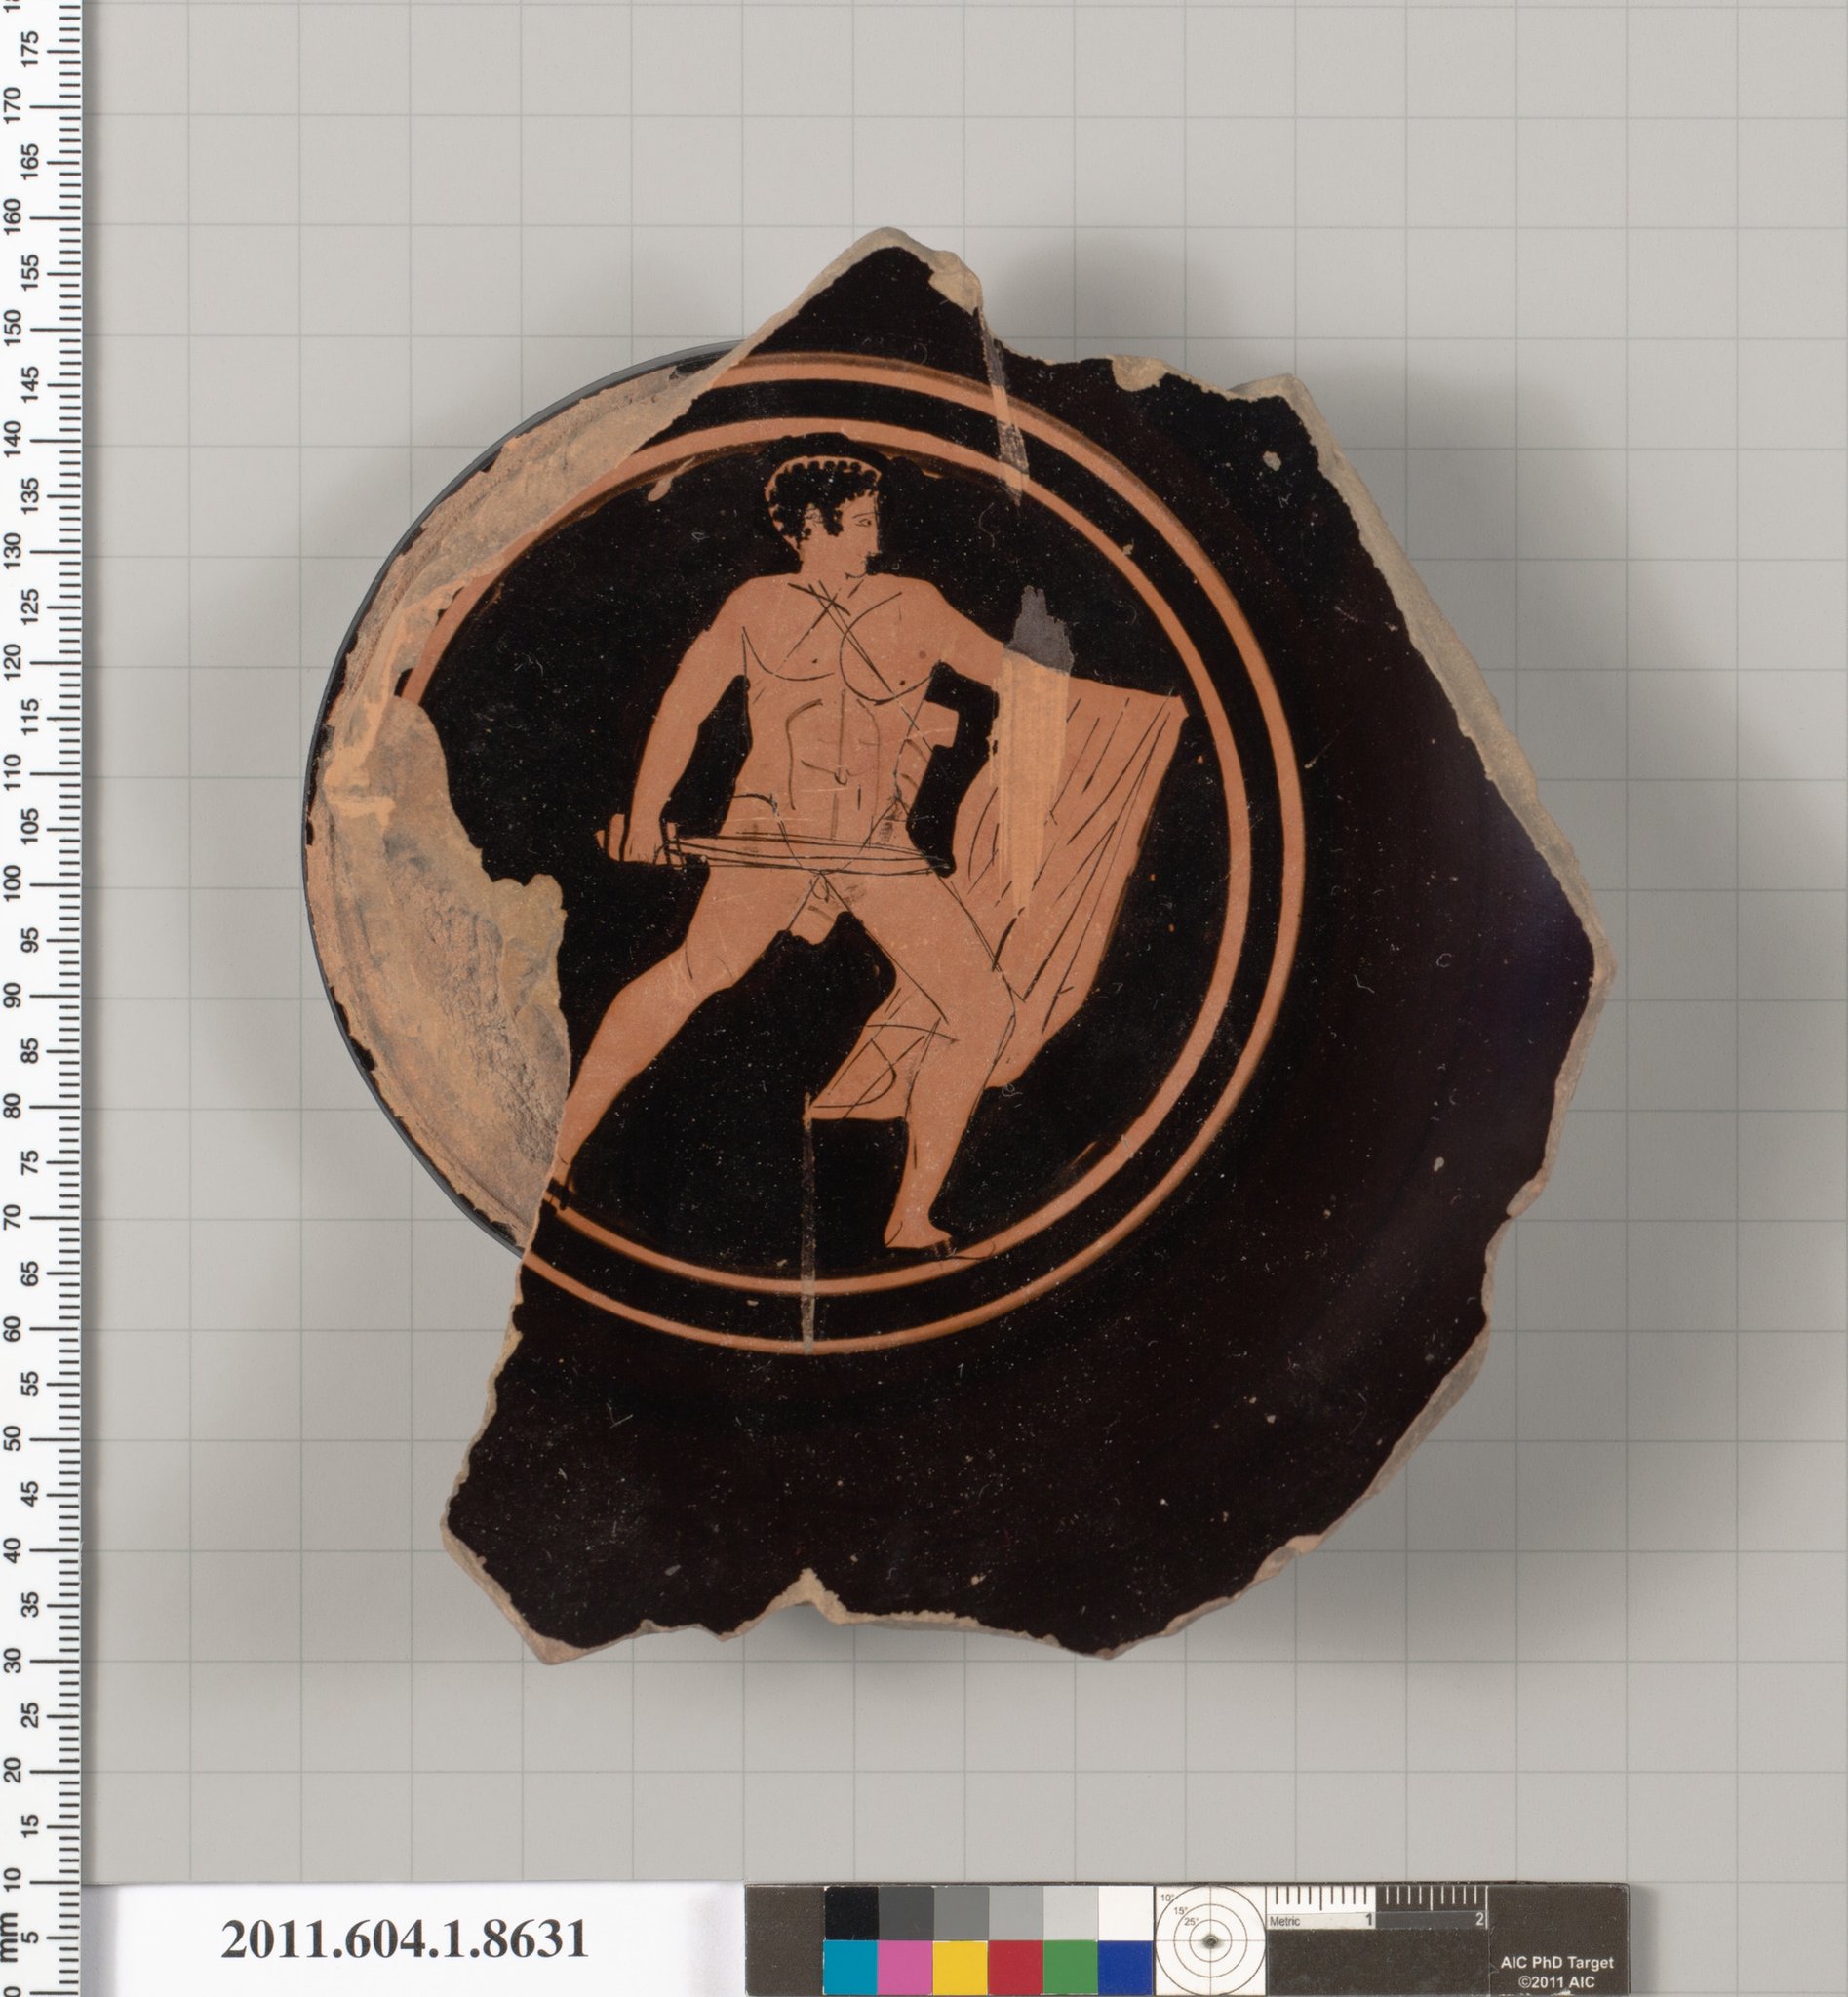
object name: kylix fragment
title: Terracotta fragment of a stemless kylix (drinking cup)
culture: greek, attic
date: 467-435 BCE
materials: terracotta